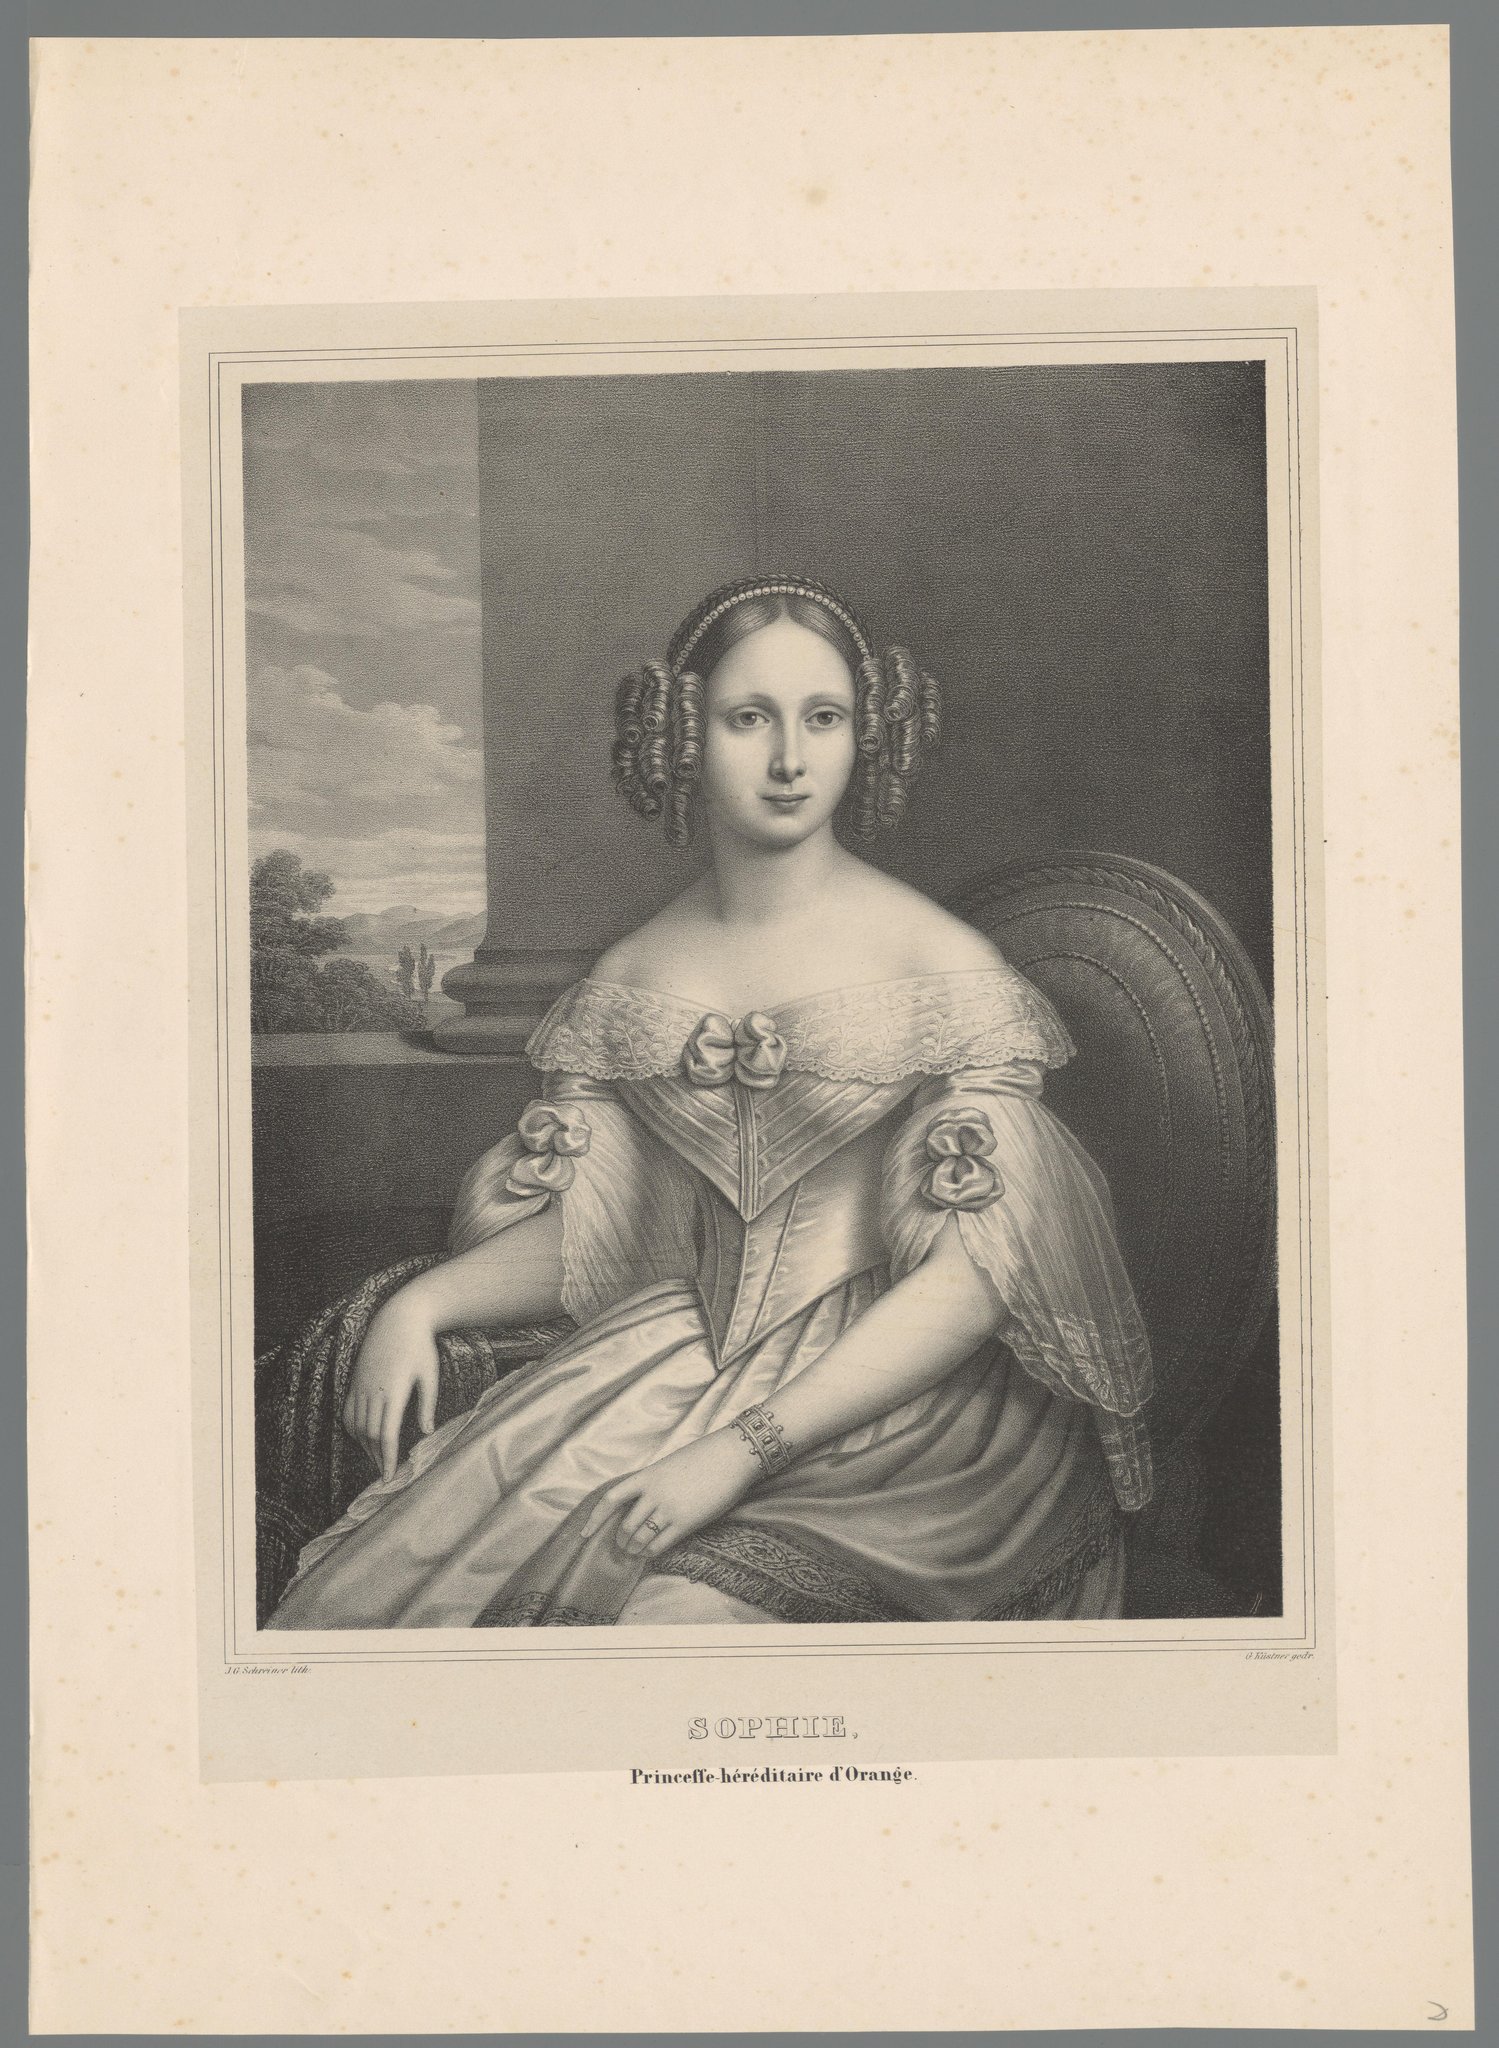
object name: print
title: Portret van Sophie, prinses der Nederlanden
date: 1811-1859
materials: paper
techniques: lithograph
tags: the hague, historical persons, princess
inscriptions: collector's mark: Lugt 963, collector's mark: Lugt 2165